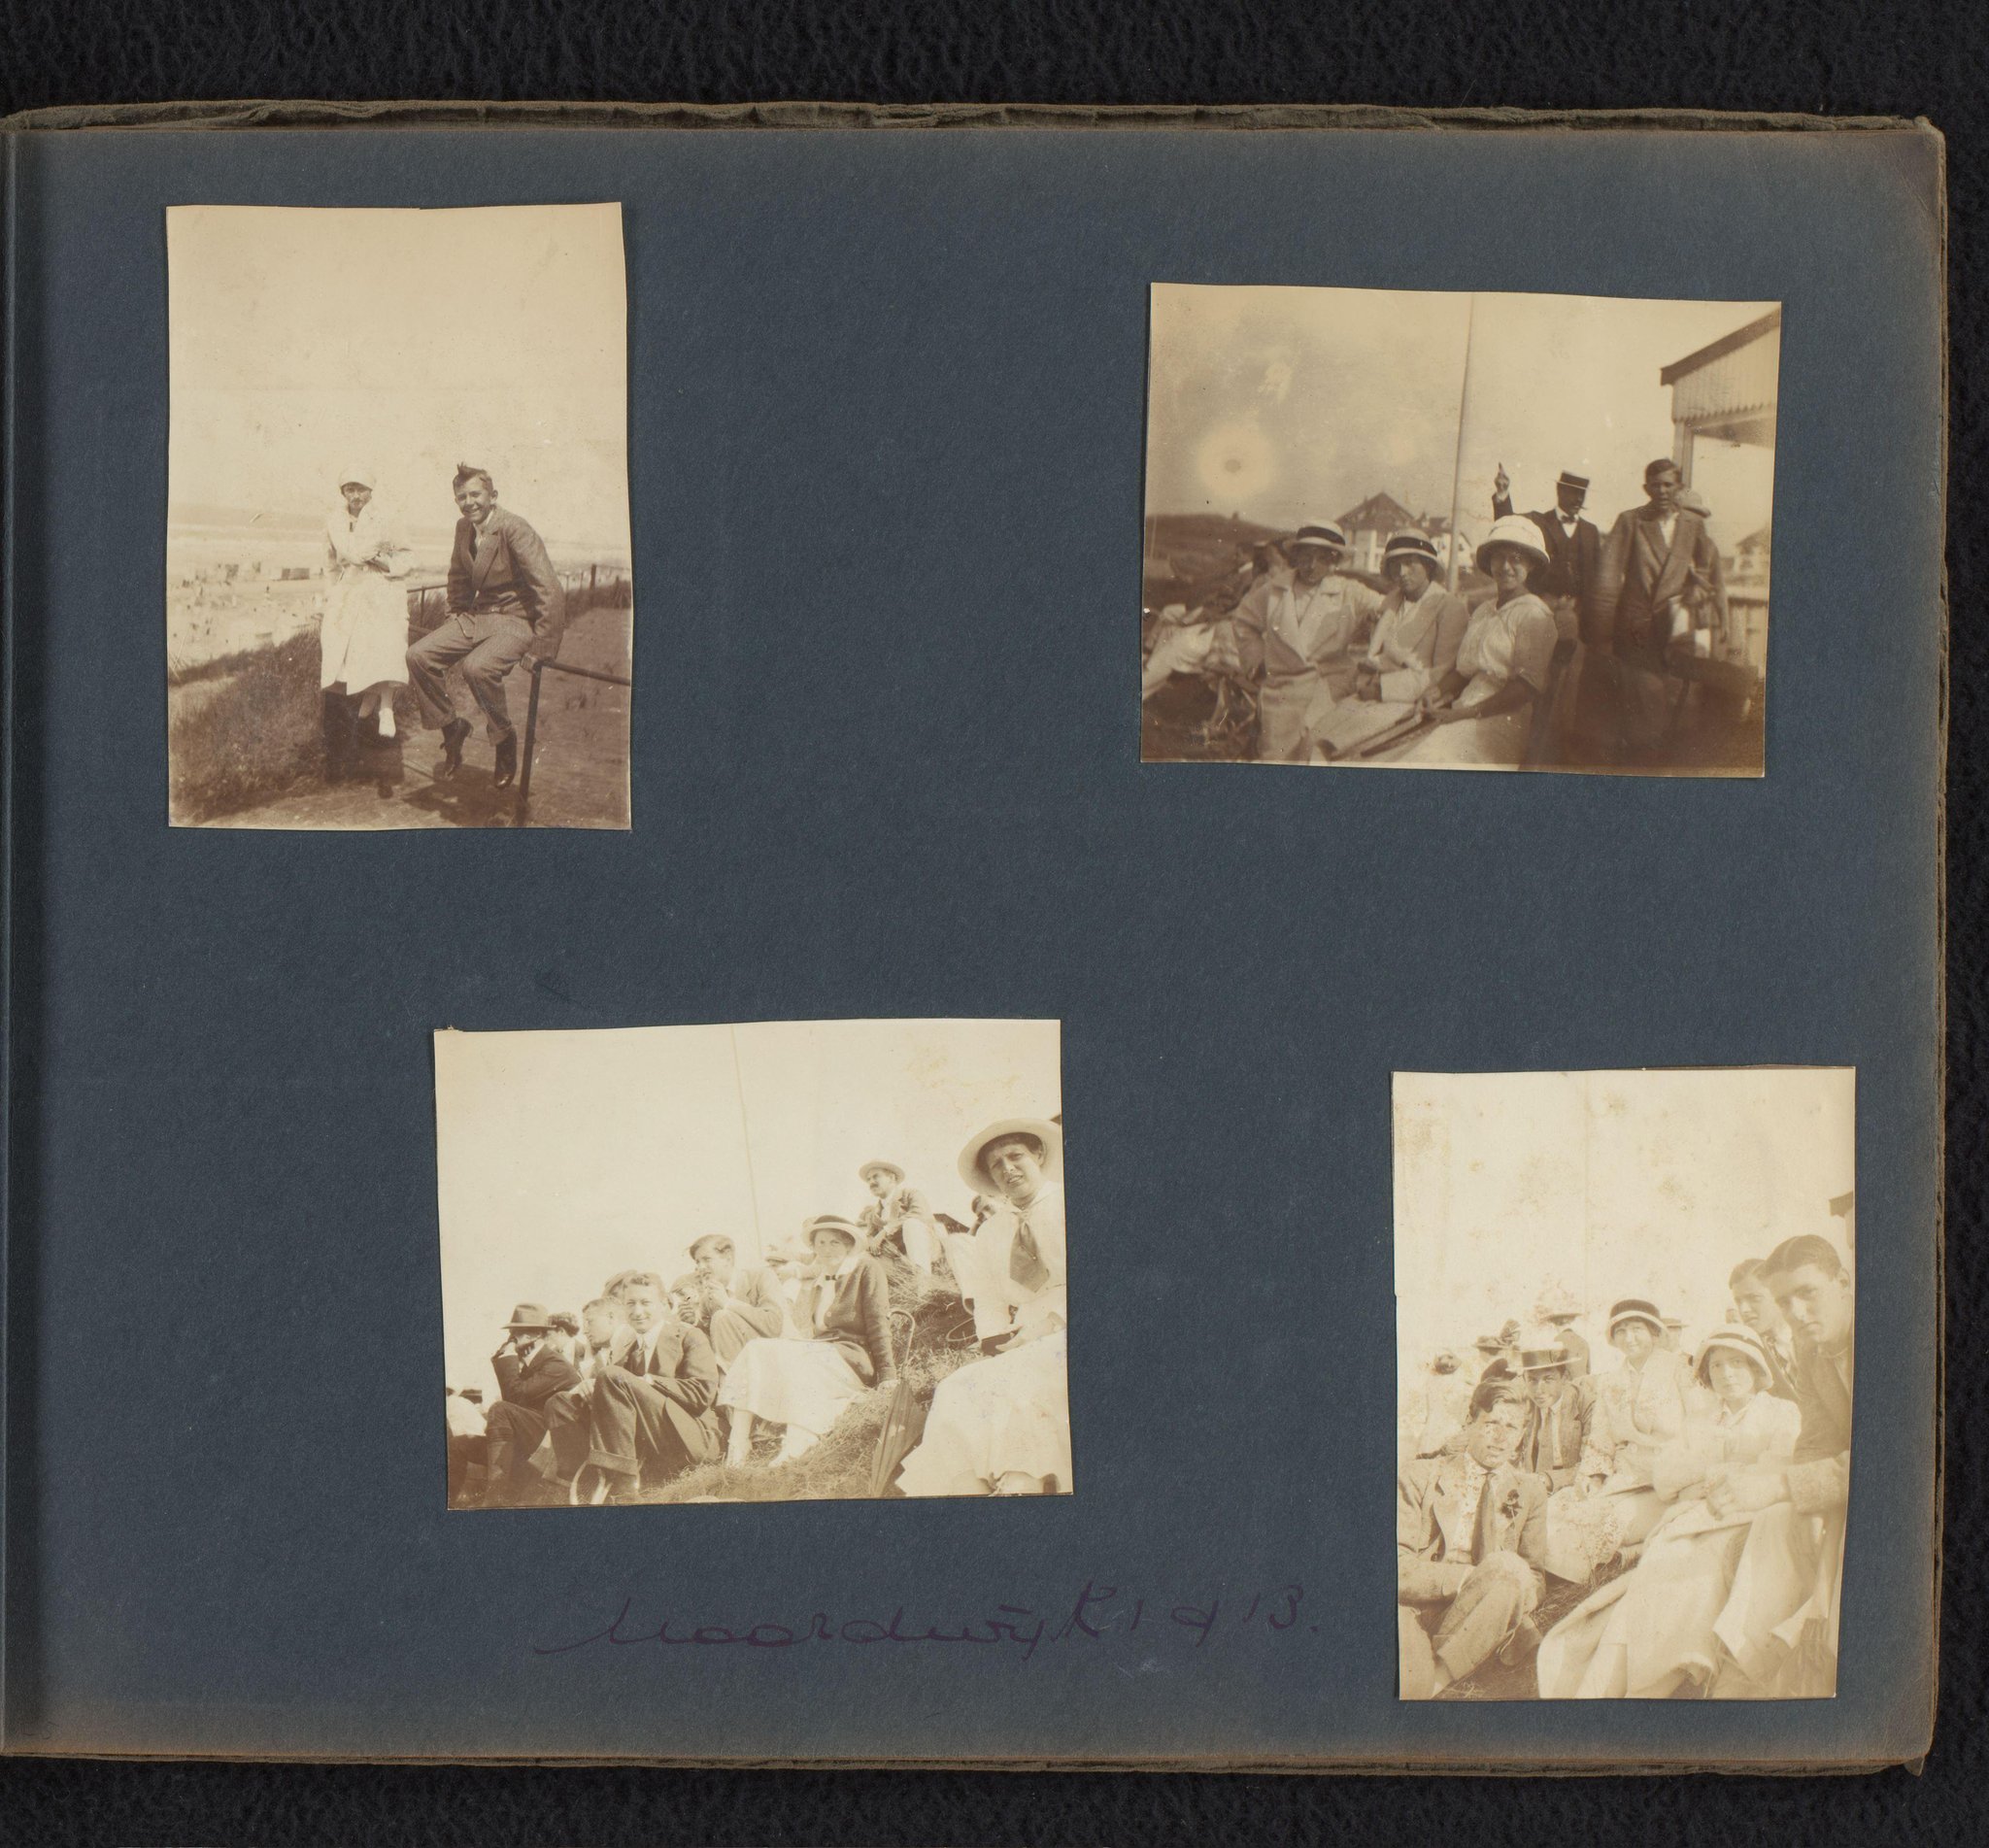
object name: photograph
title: Publiek tijdens een tenniswedstrijd in Noordwijk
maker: Anonymous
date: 1913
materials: paper, cardboard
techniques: gelatin silver print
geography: noordwijk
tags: tennis, lawn-tennis, anonymous historical person portrayed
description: Deze foto's zijn onderdeel van een album.